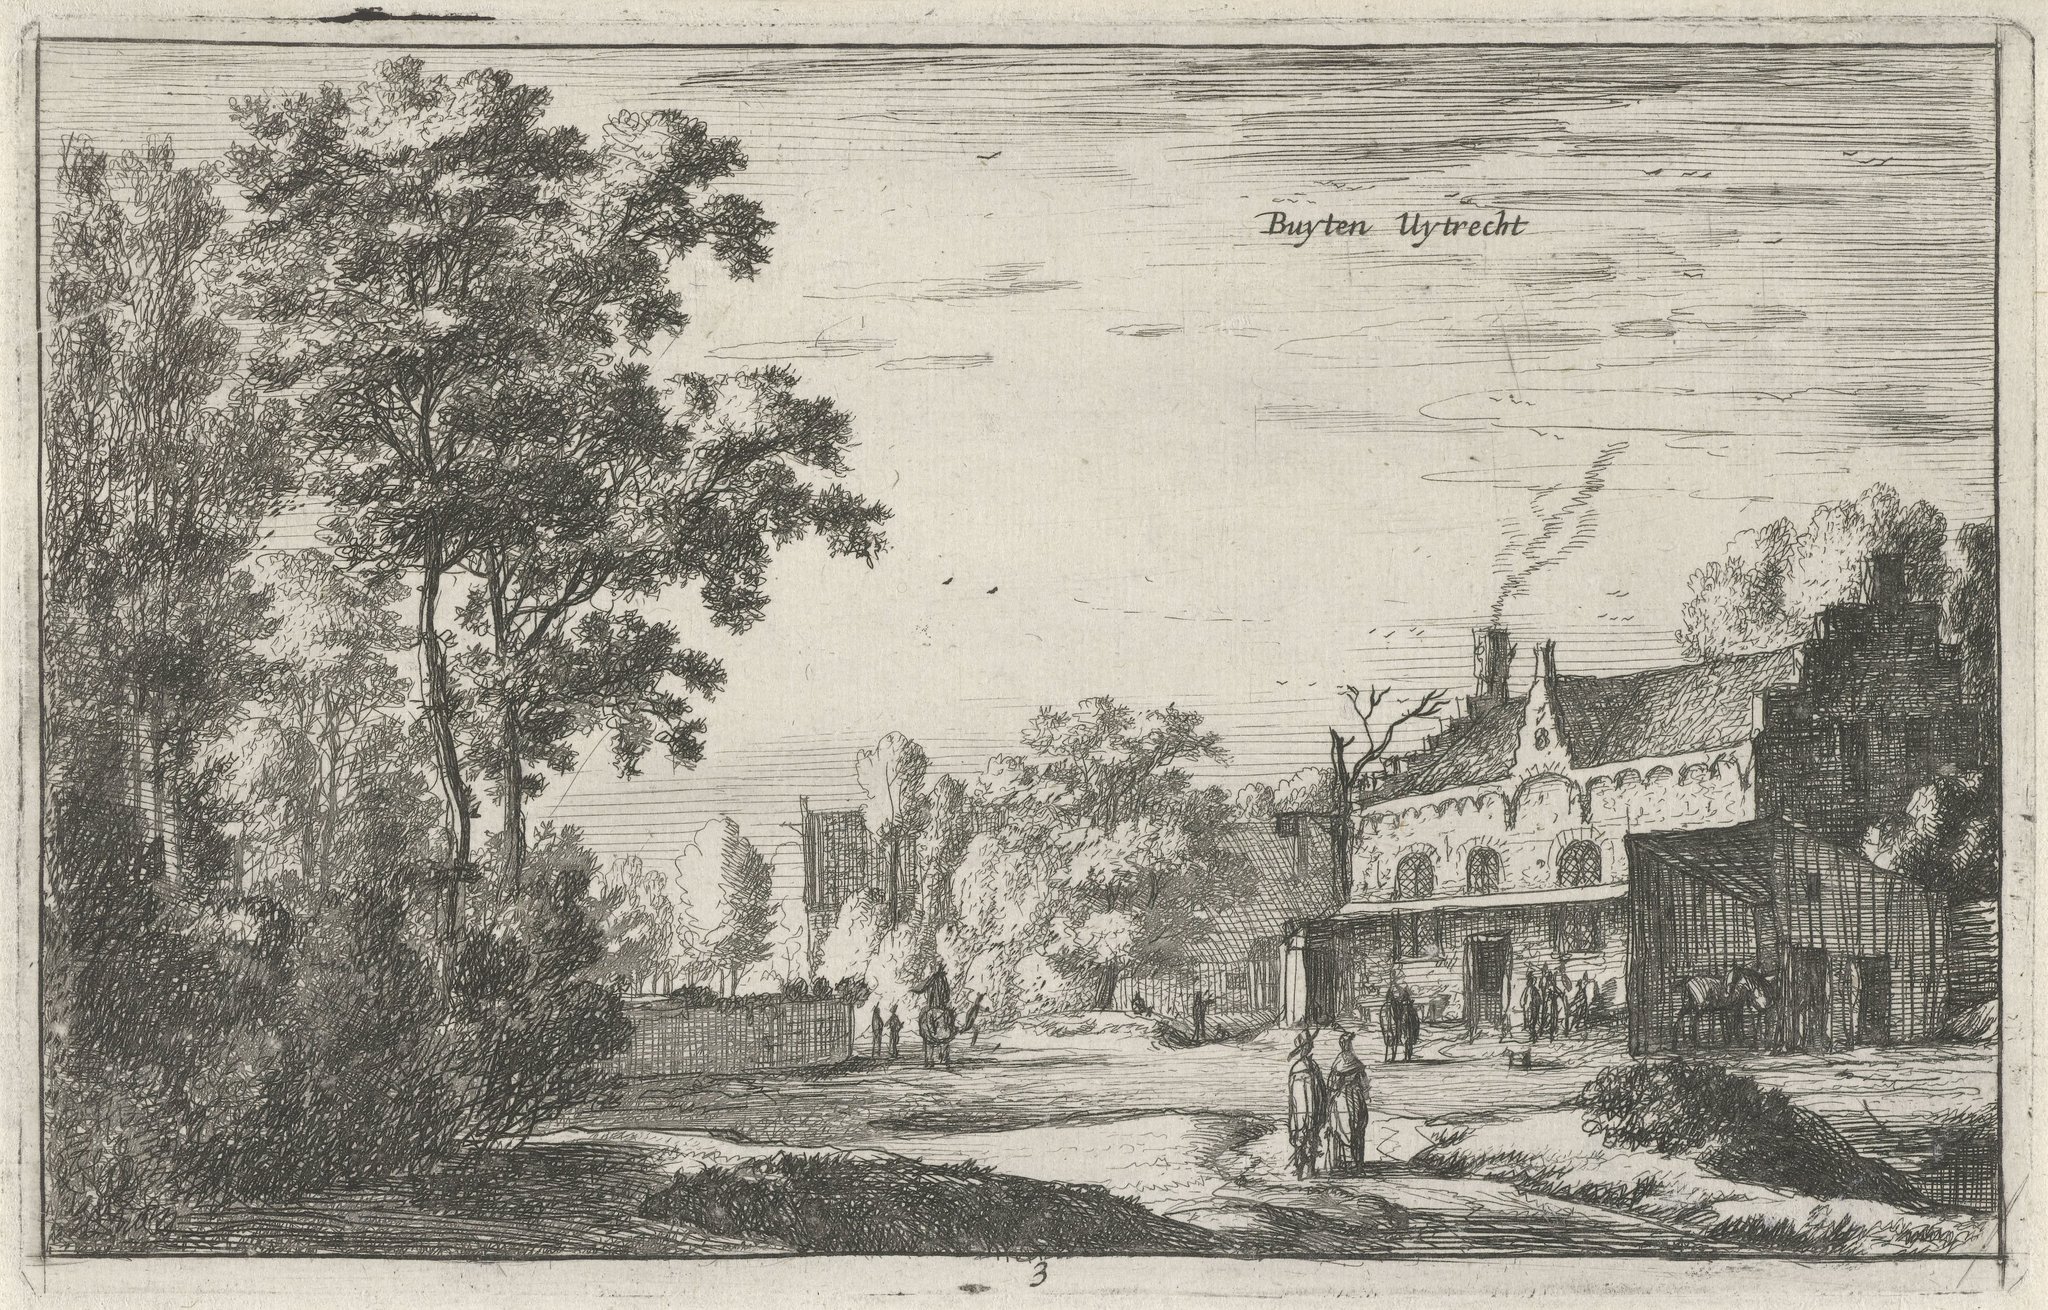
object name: print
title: Landschappen in de Noordelijke Nederlanden (Roelant Roghman)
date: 1637-1677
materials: paper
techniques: drypoint, etching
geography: amsterdam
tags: rural housing, e.g. country-house, villa, cottage, forest, wood, horse, dog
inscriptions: collector's mark: Lugt 240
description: Gezicht vanuit een bos op enkele huizen in de omgeving van Utrecht. Rechts mogelijk een herberg. Op de voorgrond een aantal passanten. Genummerd onderaan in de marge: 3.